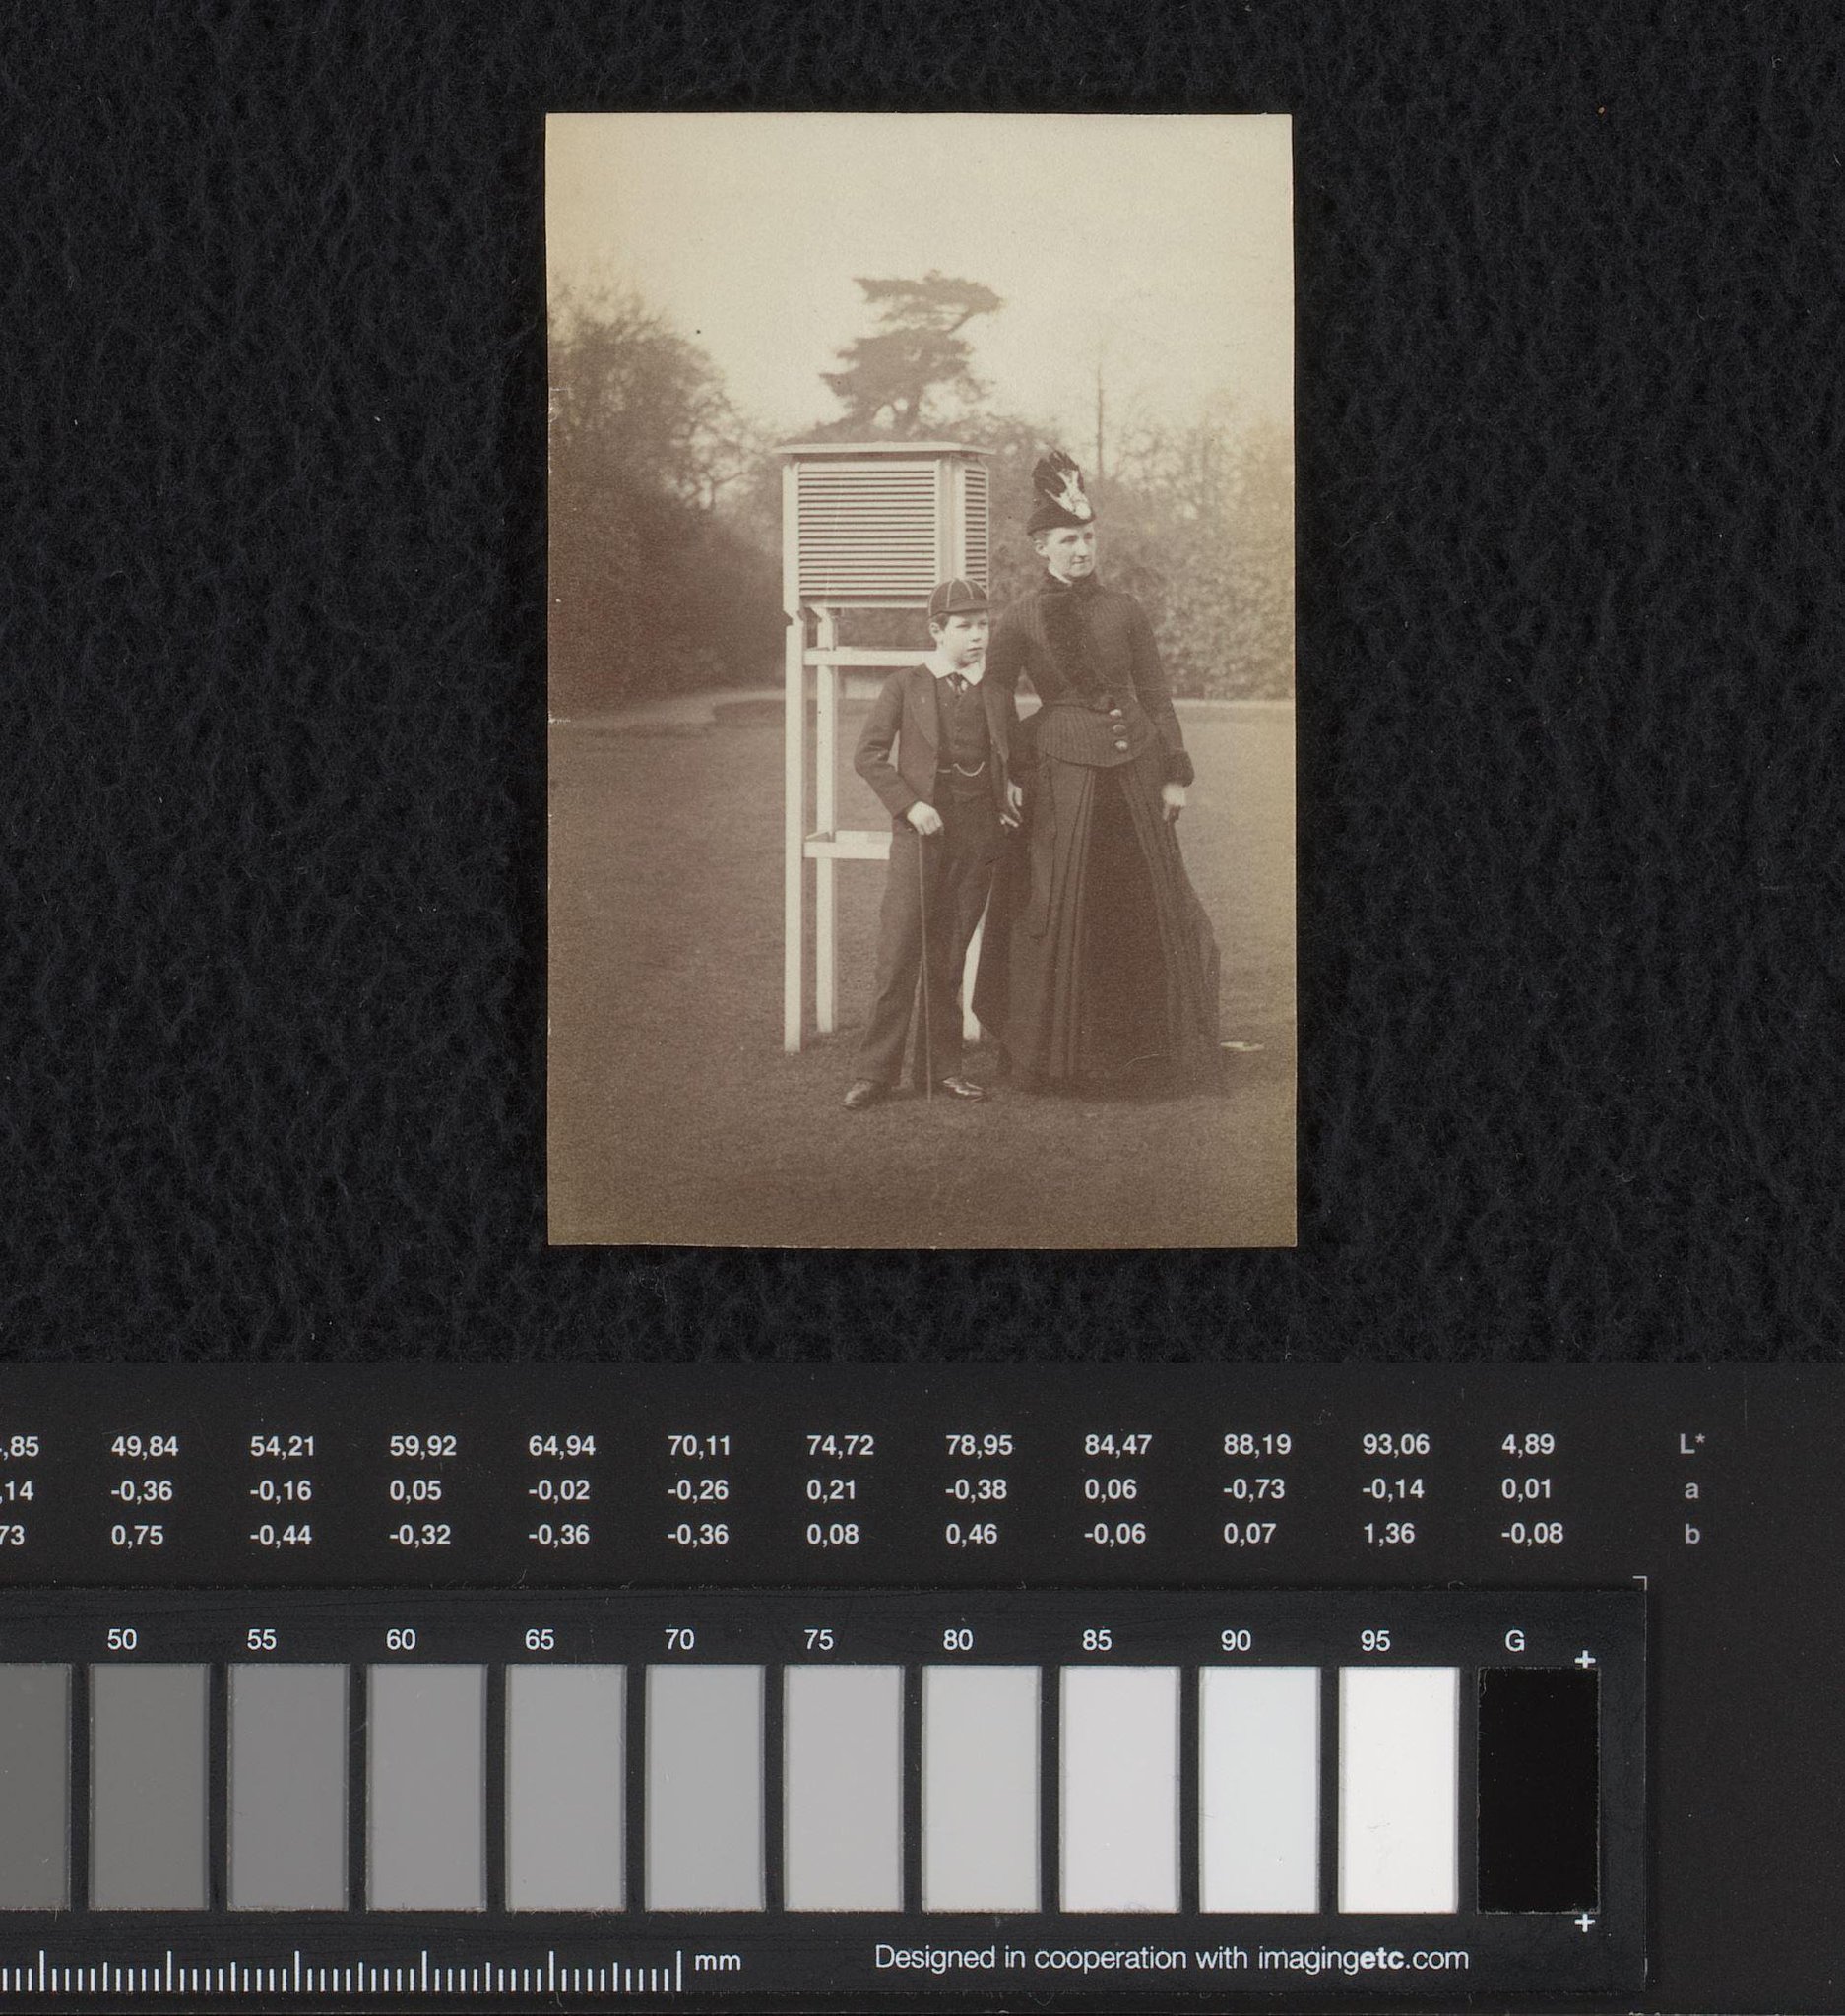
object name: photograph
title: Vrouw en jongen in een tuin, vermoedelijk bij een bijenkast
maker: Anonymous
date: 1860-1890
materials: photographic support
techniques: albumen print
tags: mother and son(s) (family group), bee-hive